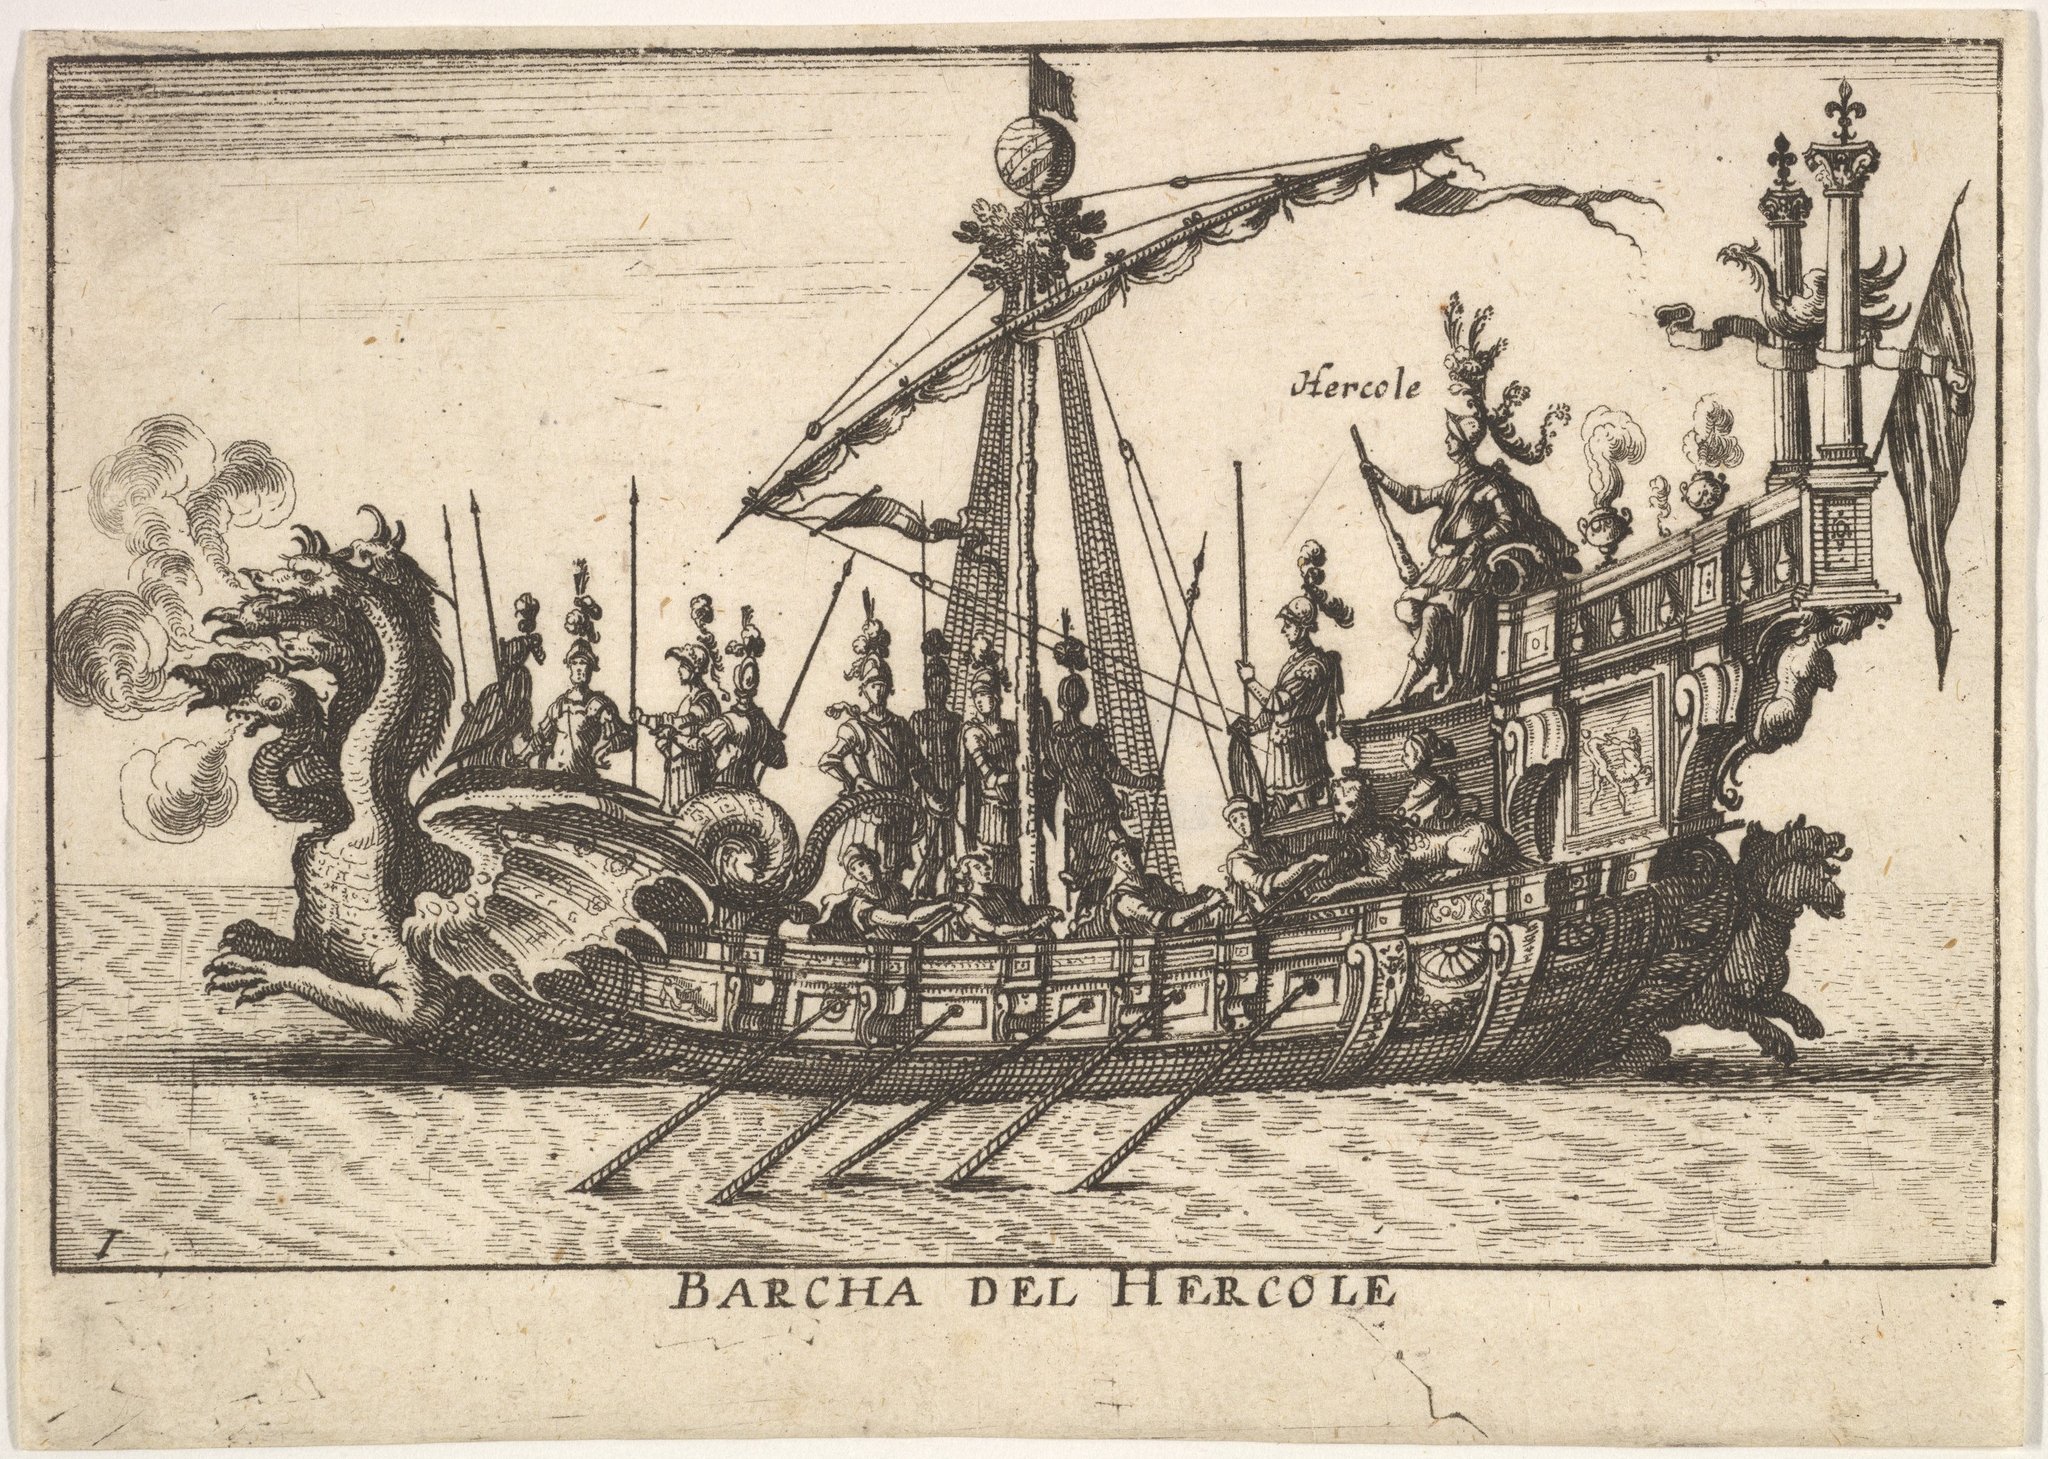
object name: print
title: Plate 1: Ship of Hercules (Barcha del Hercole), with dragon-headed prow and Hercules on platform behind oarsmen and standing soldiers, from "The magnificent pageant on the river Arno in Florence for the marriage of the Grand Duke" (Le Magnifique carousel fait sur le fleuve de l'Arne a Florence, pour le mariage du Grand Duc)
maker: Anonymous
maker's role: artist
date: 1664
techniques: etching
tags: men,dragons,ships